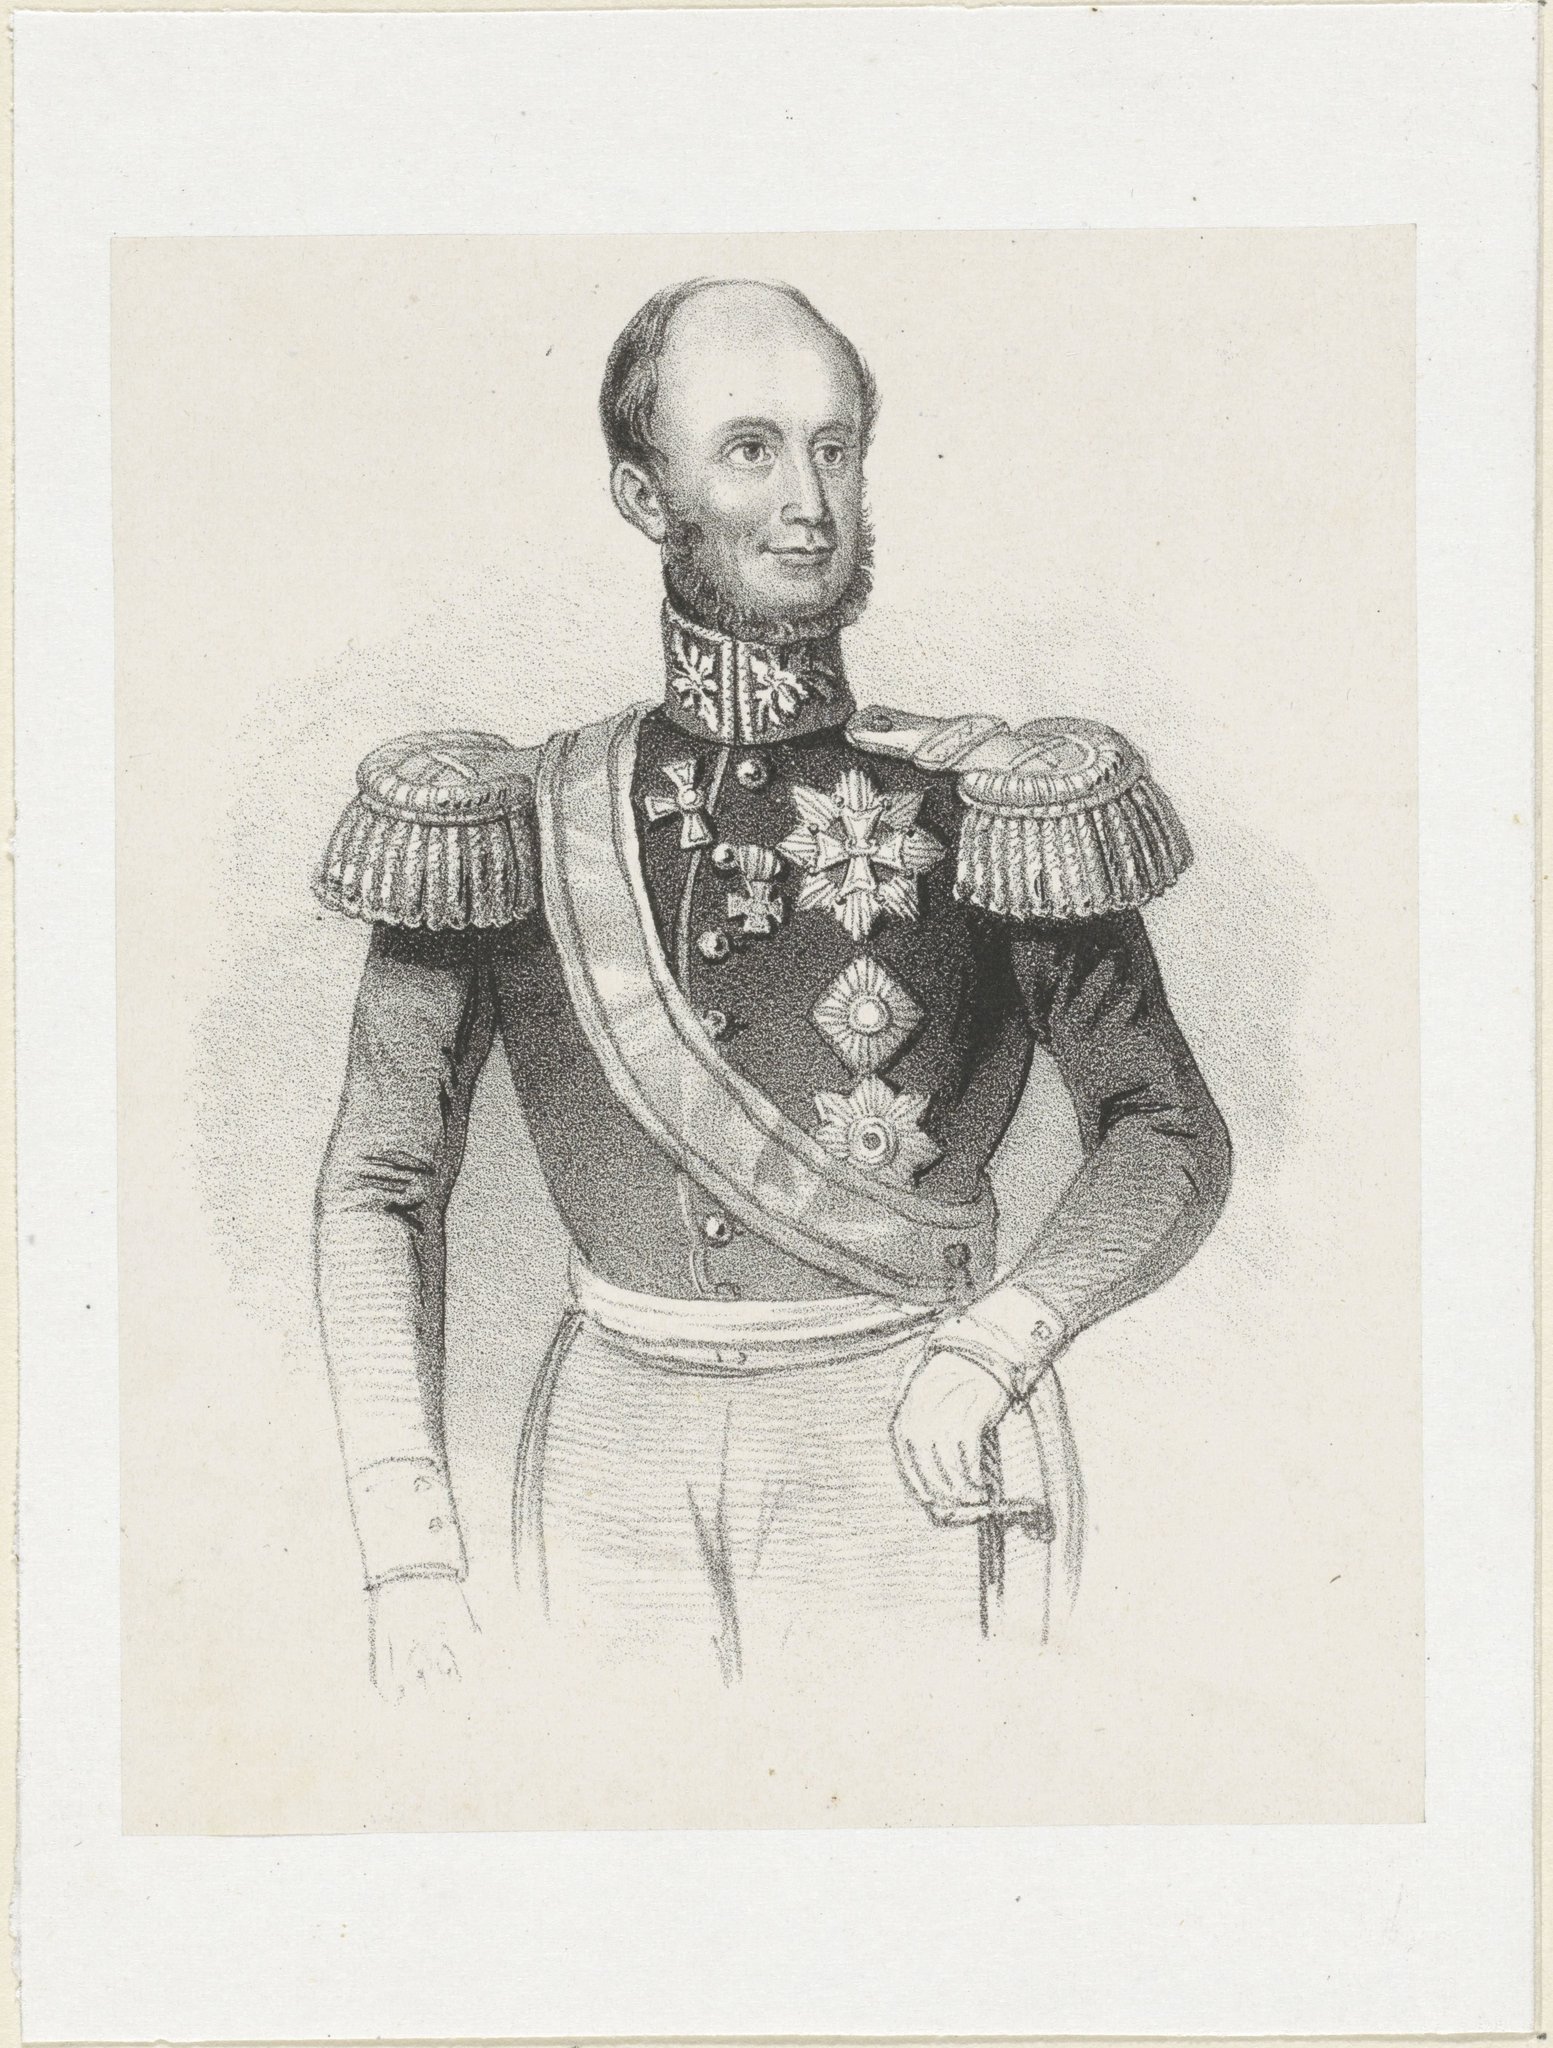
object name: print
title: Portret van Willem II, koning der Nederlanden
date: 1840-1863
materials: paper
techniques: lithograph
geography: the hague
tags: the hague, william ii of the netherlands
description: De hier vermelde titel verwijst naar de hoogst verkregen titel van de geportretteerde, niet per se naar de titel die de geportretteerde op deze voorstelling draagt.